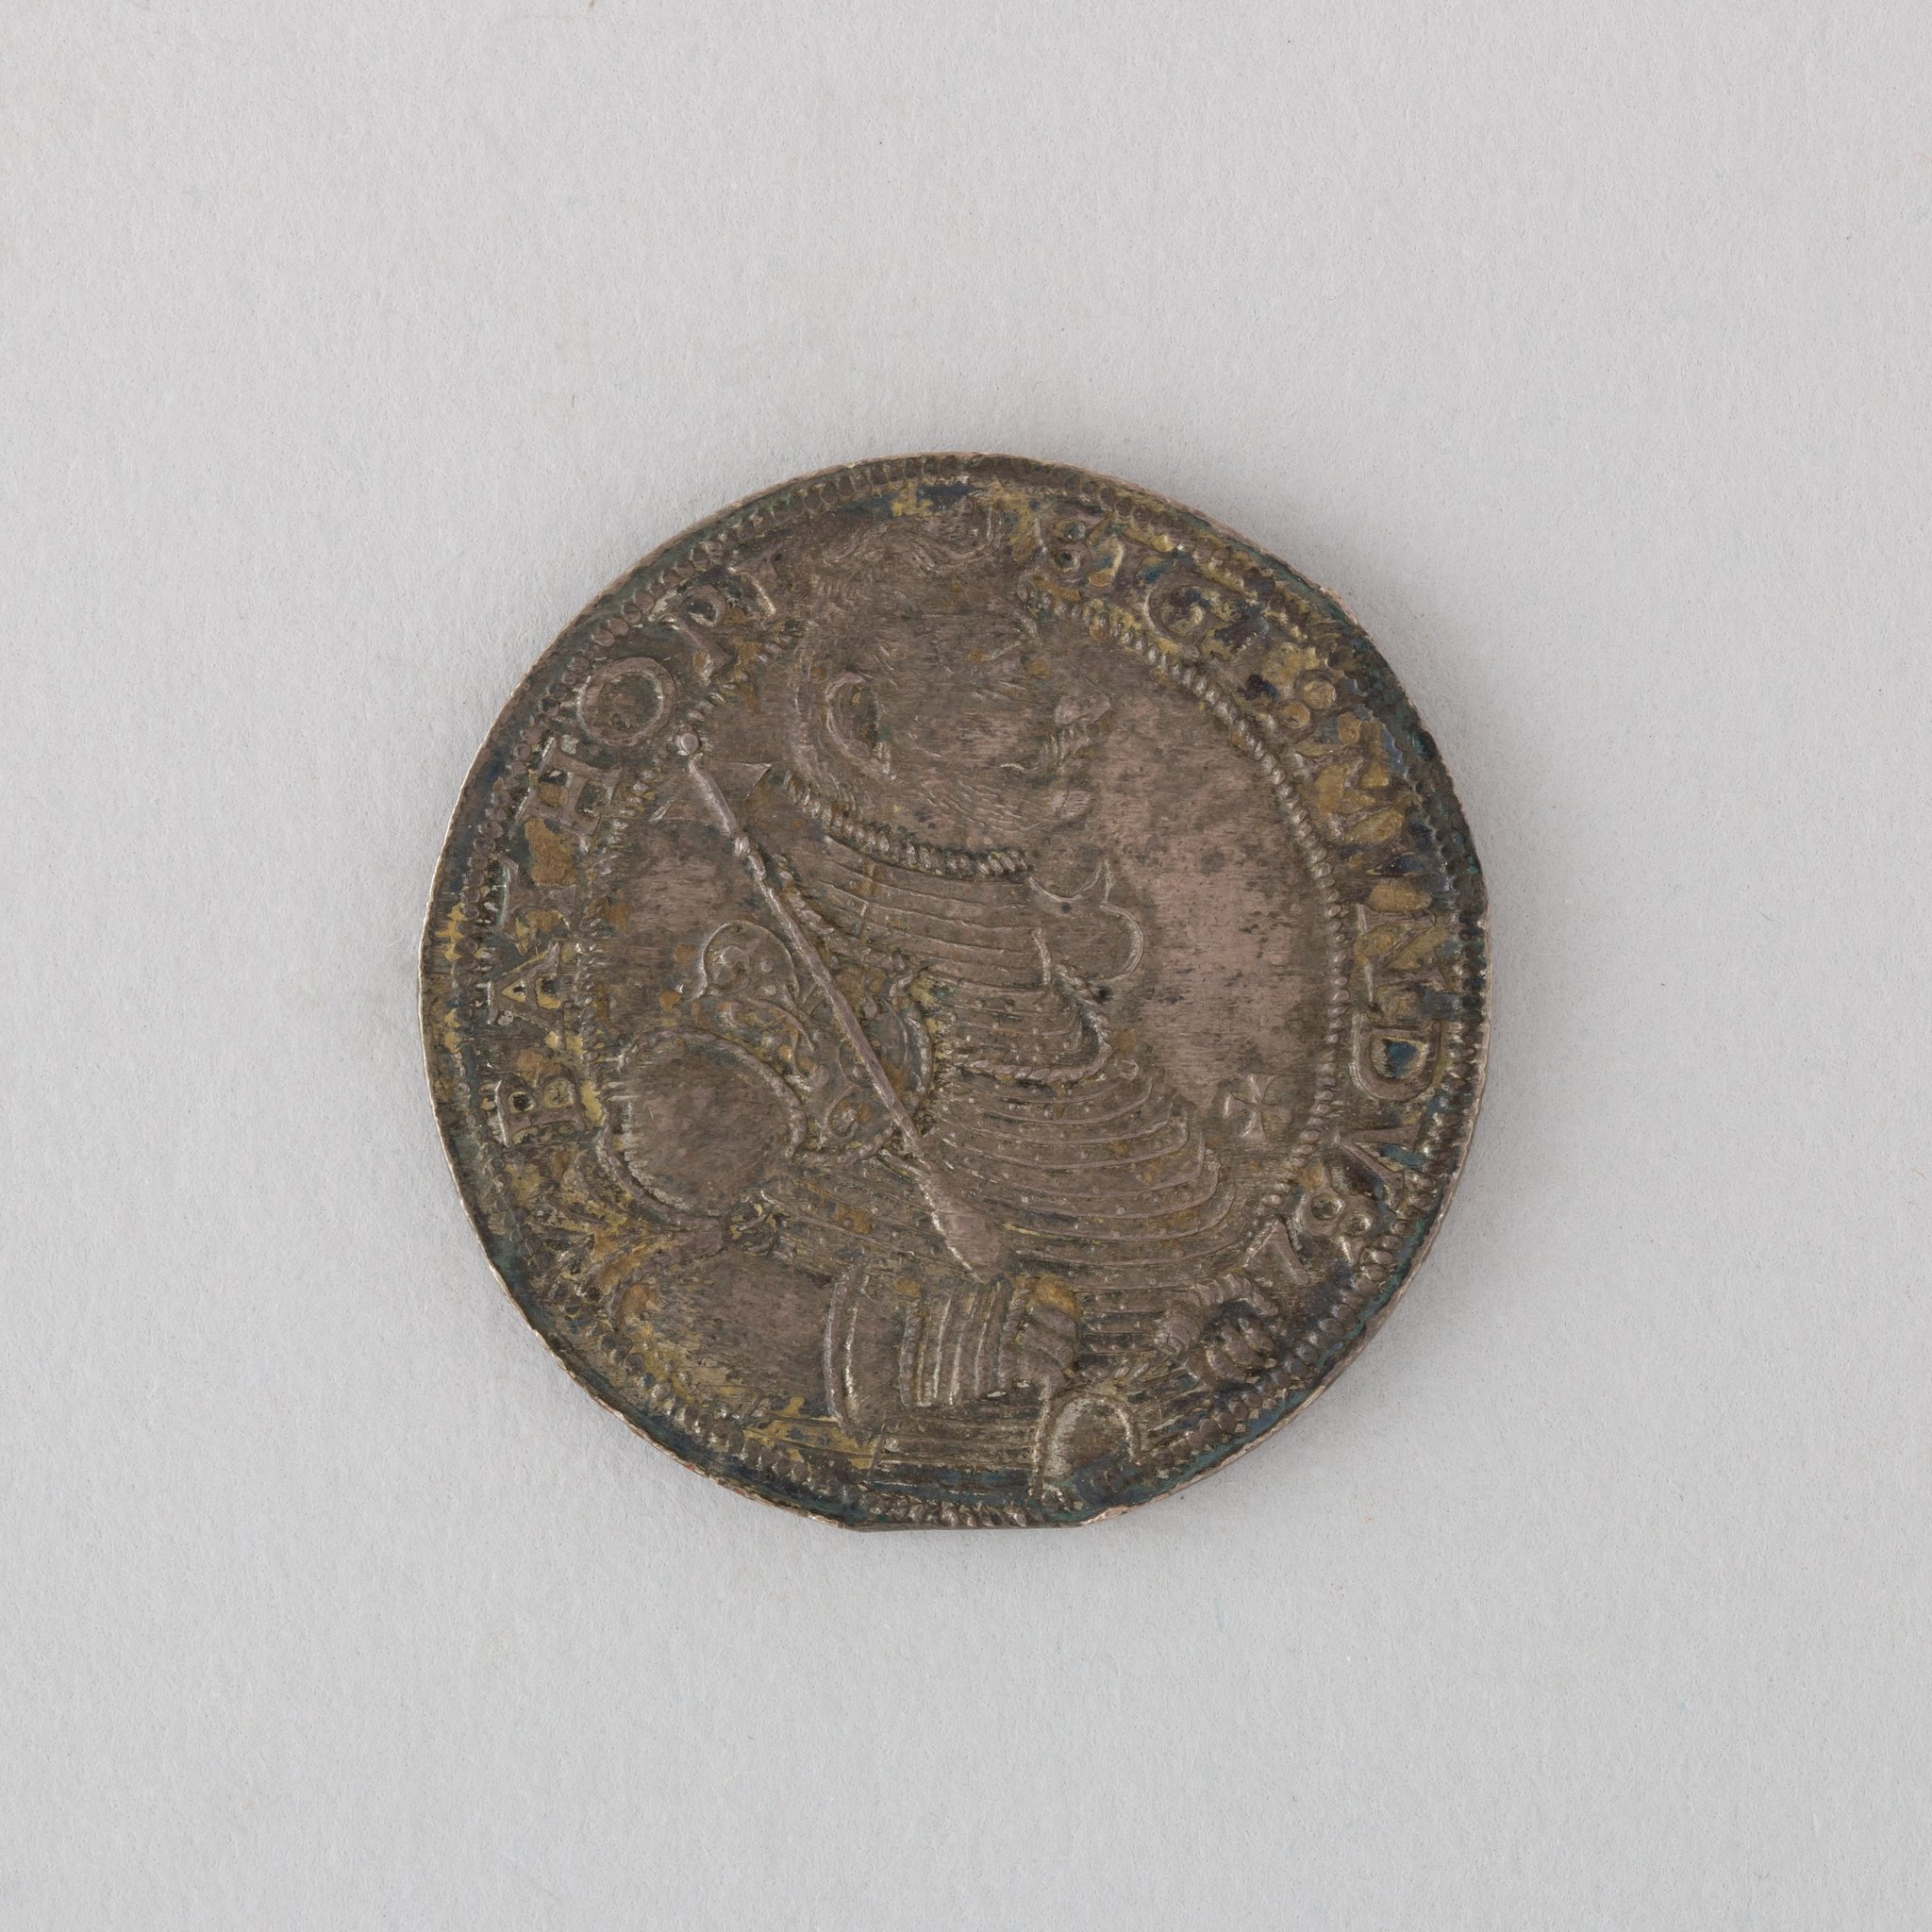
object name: coin thaler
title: Coin (Thaler) Showing Prince Sigismund Báthori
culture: hungarian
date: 1593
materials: silver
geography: hungary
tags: princes,coins